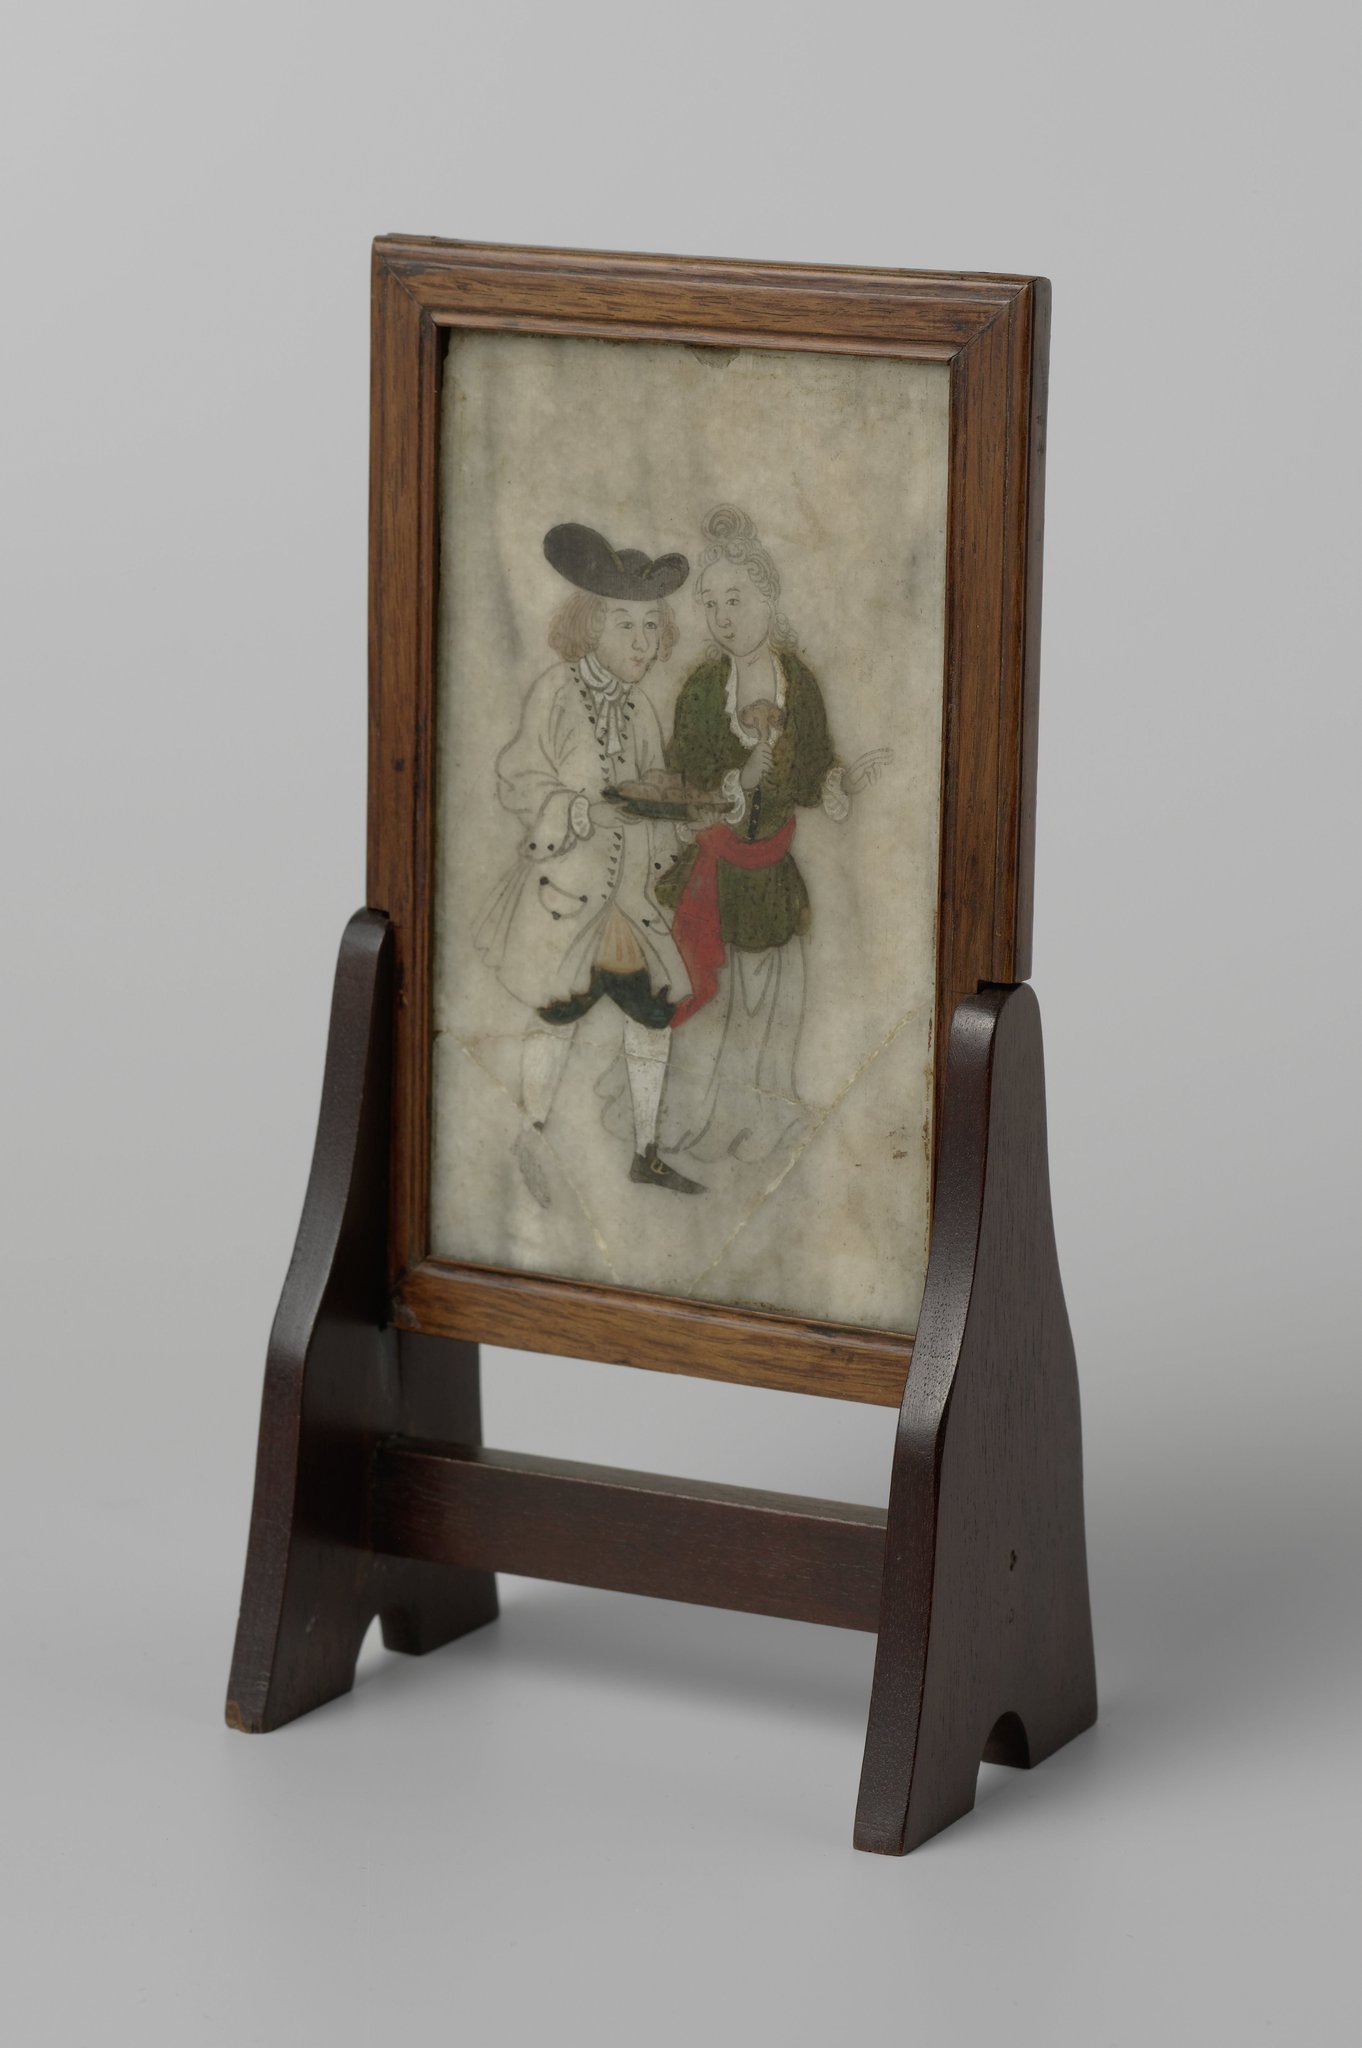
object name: table screen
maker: Anonymous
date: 1750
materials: marble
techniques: polychromy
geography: china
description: Spatscherm; heer en dame in westerse kledij met inscriptie.